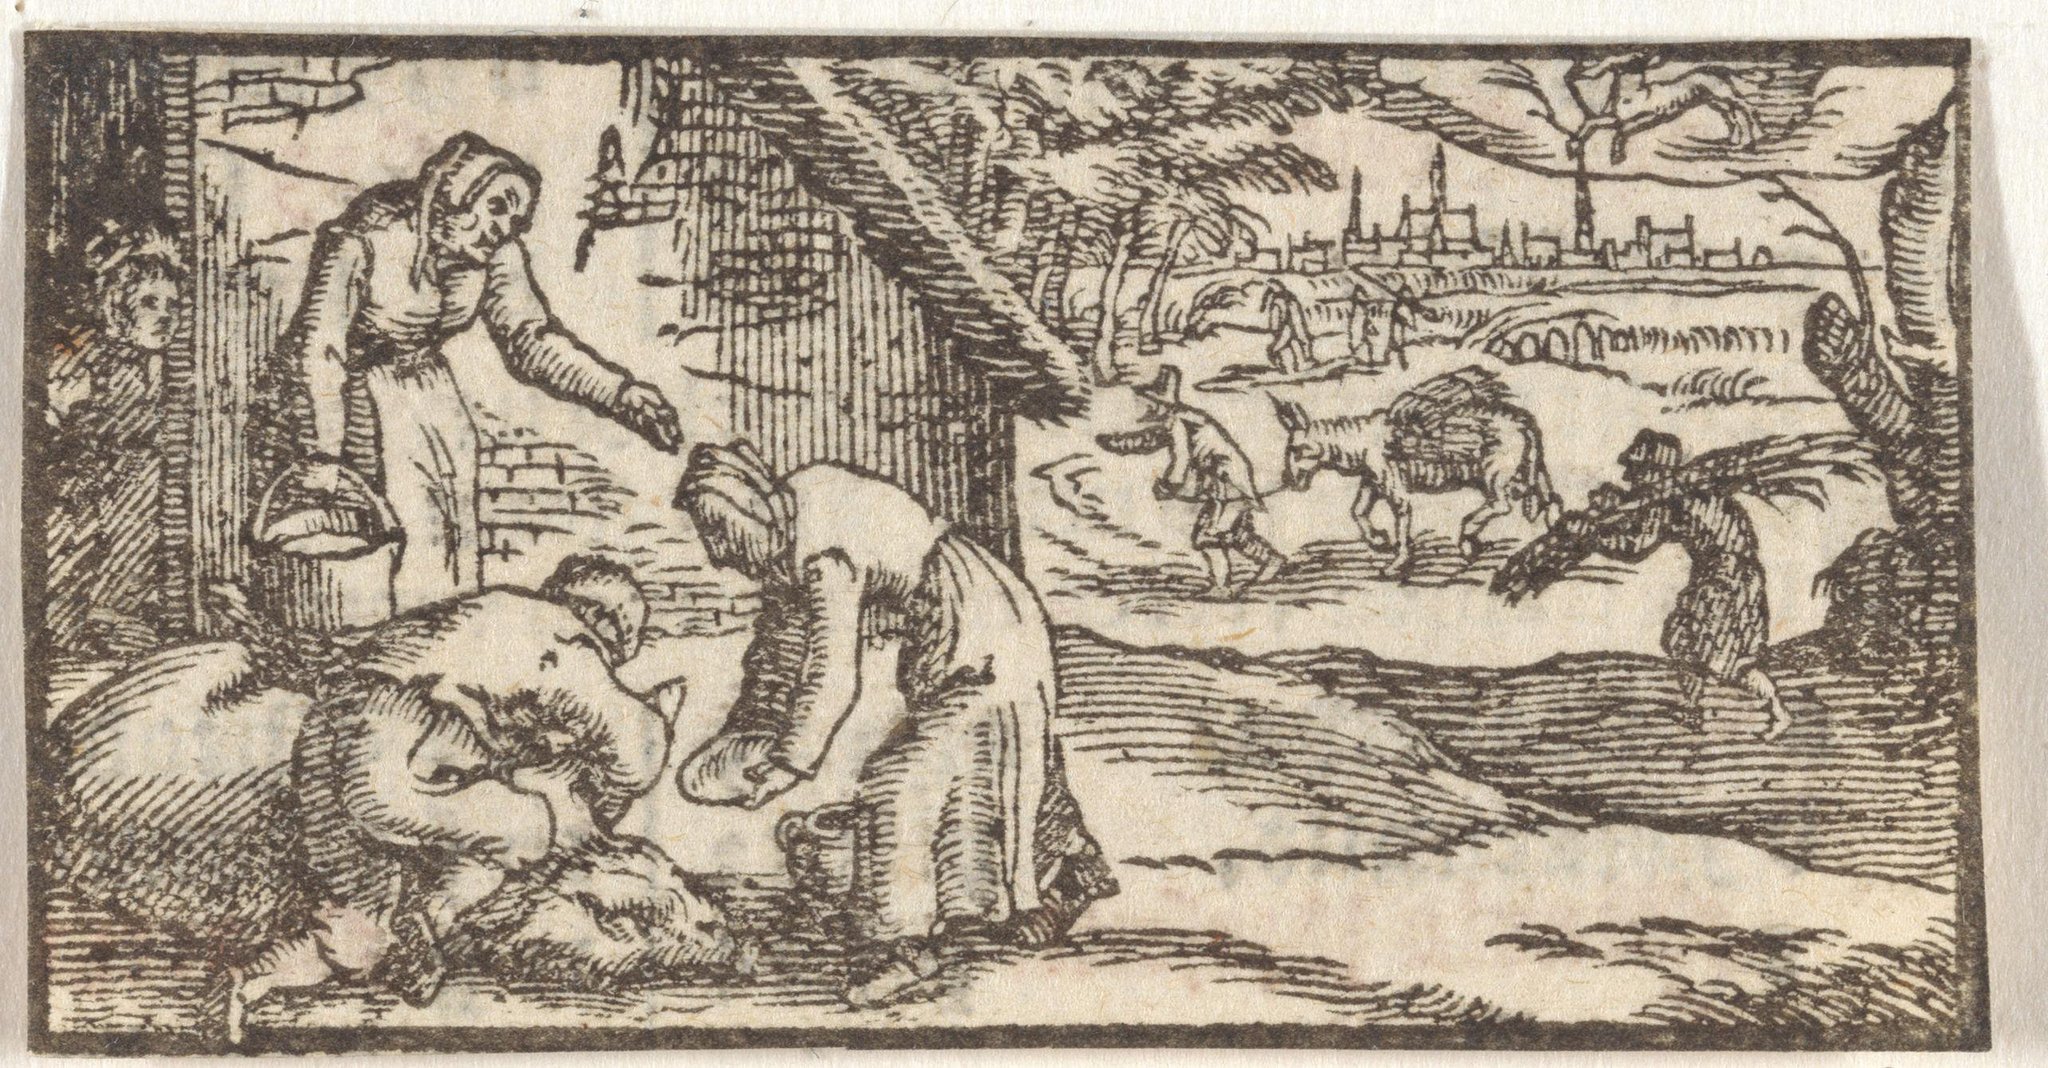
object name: book illustration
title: Maanden van het jaar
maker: Anonymous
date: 1600-1699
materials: paper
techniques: letterpress printing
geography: netherlands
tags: harvest, november and its 'labours' (+ with sagittarius (november))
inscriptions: collector's mark: Lugt 2228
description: Drie figuren een koe slachtend. Op de achtergrond figuren werkend op het land. Rechtsboven een boogschutter.